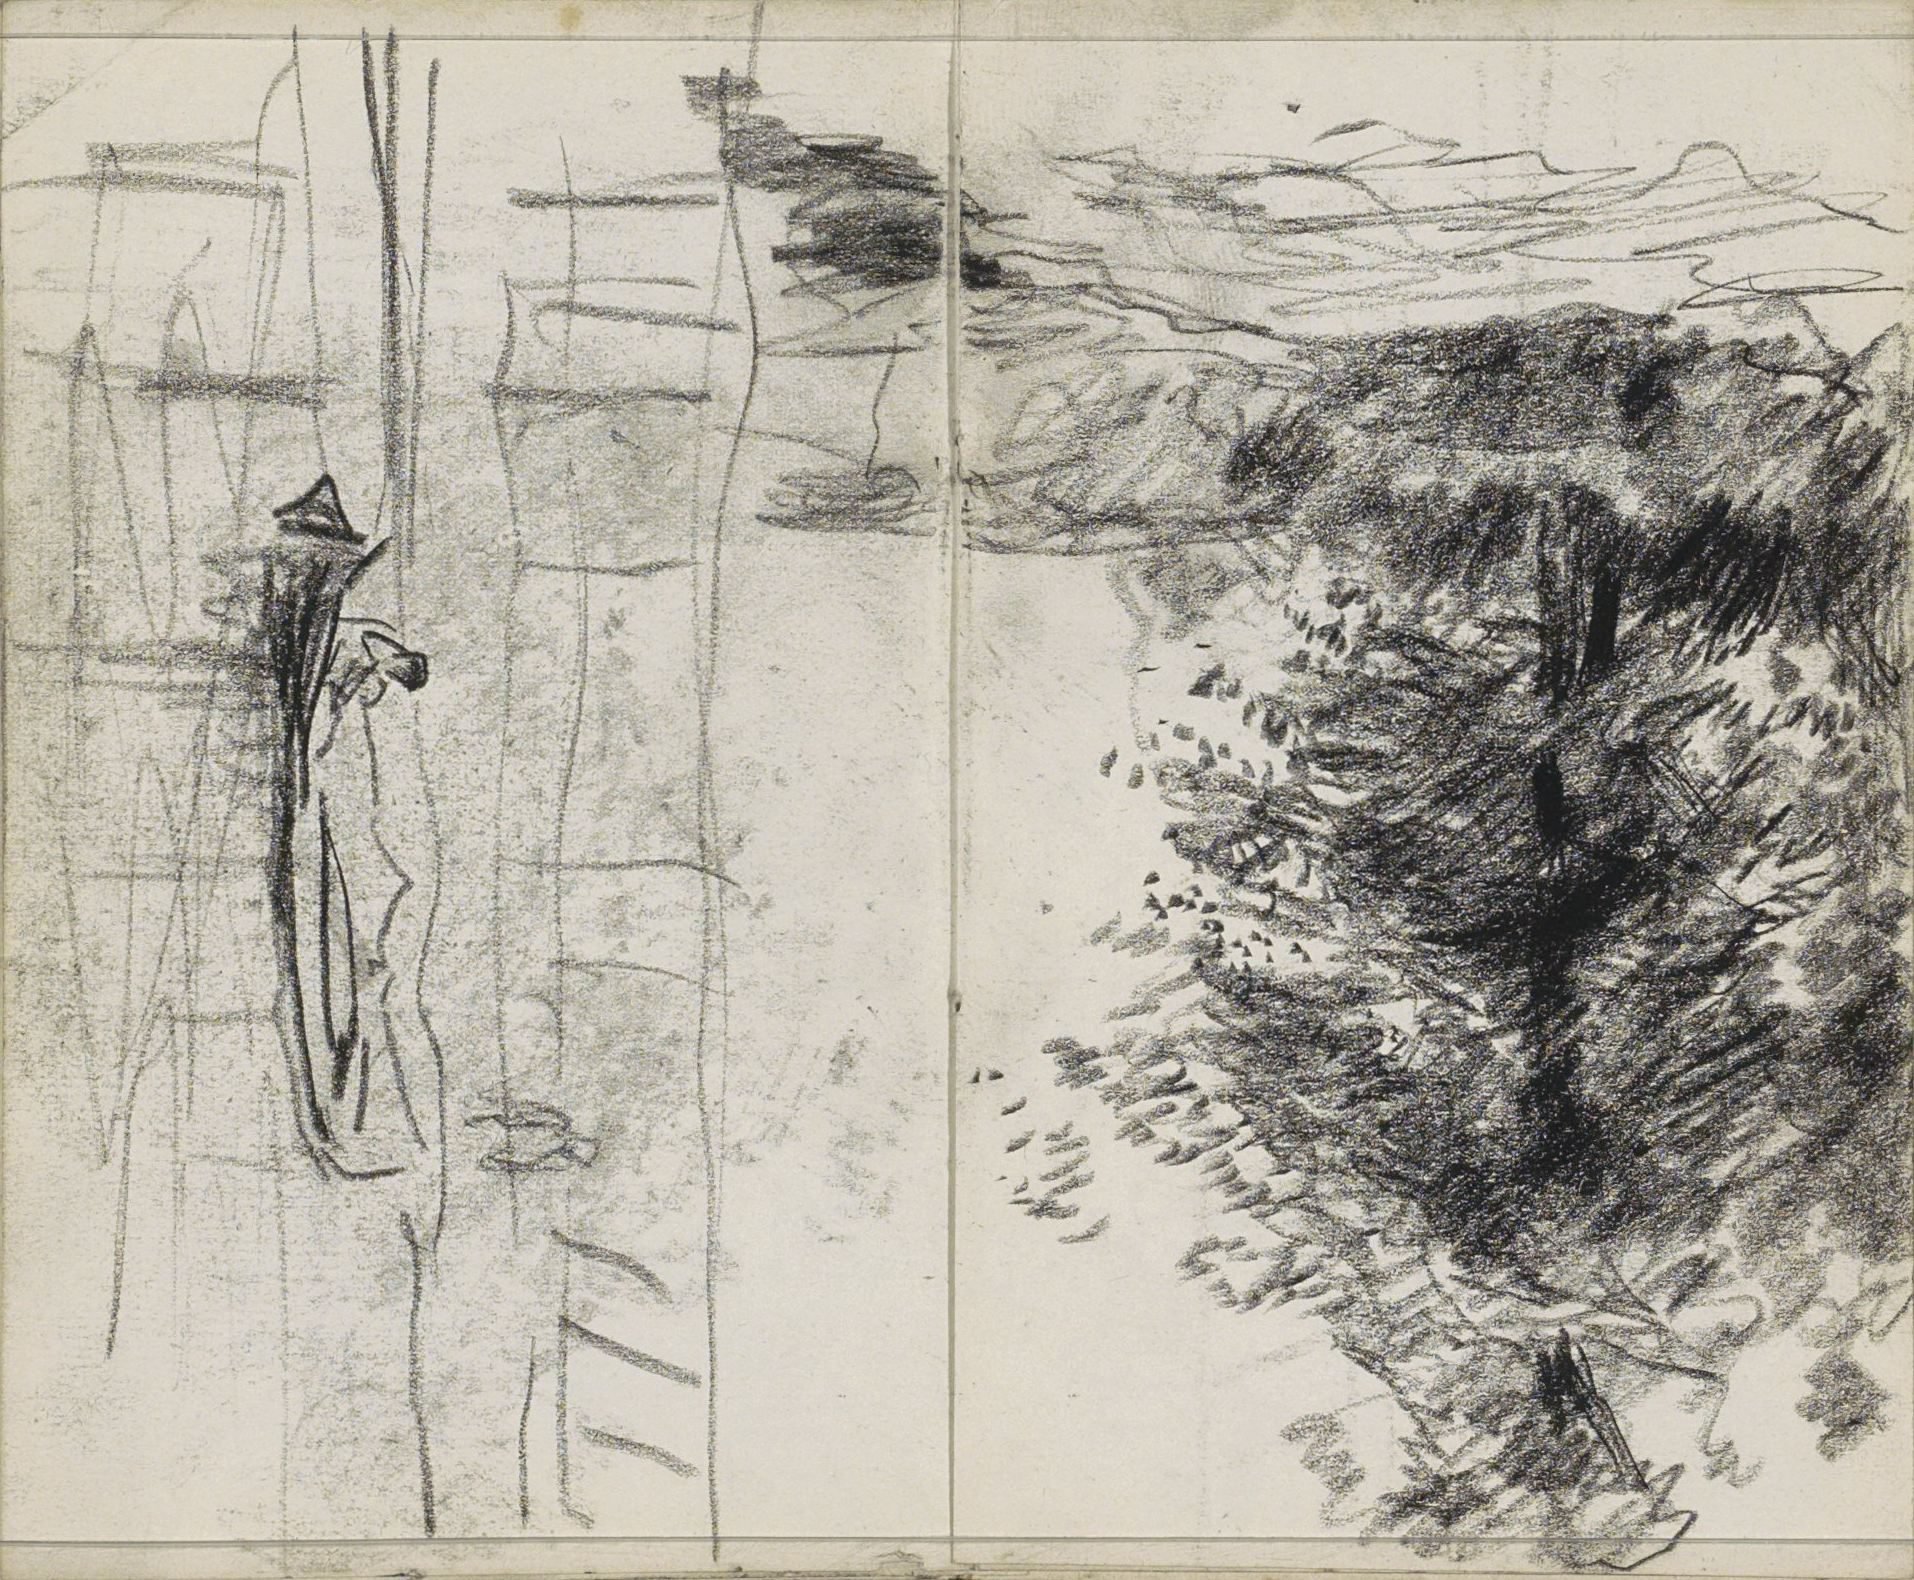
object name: sketchbook leaf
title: Figuur in een roeiboot en een boom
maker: anton mauve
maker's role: draughtsman, painter, print maker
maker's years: 1838-1888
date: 1848-1888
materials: chalk, paper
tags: trees, rowing-boat, canoe, etc.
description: Blad 25 verso en 26 recto uit een schetsboek met 53 bladen.